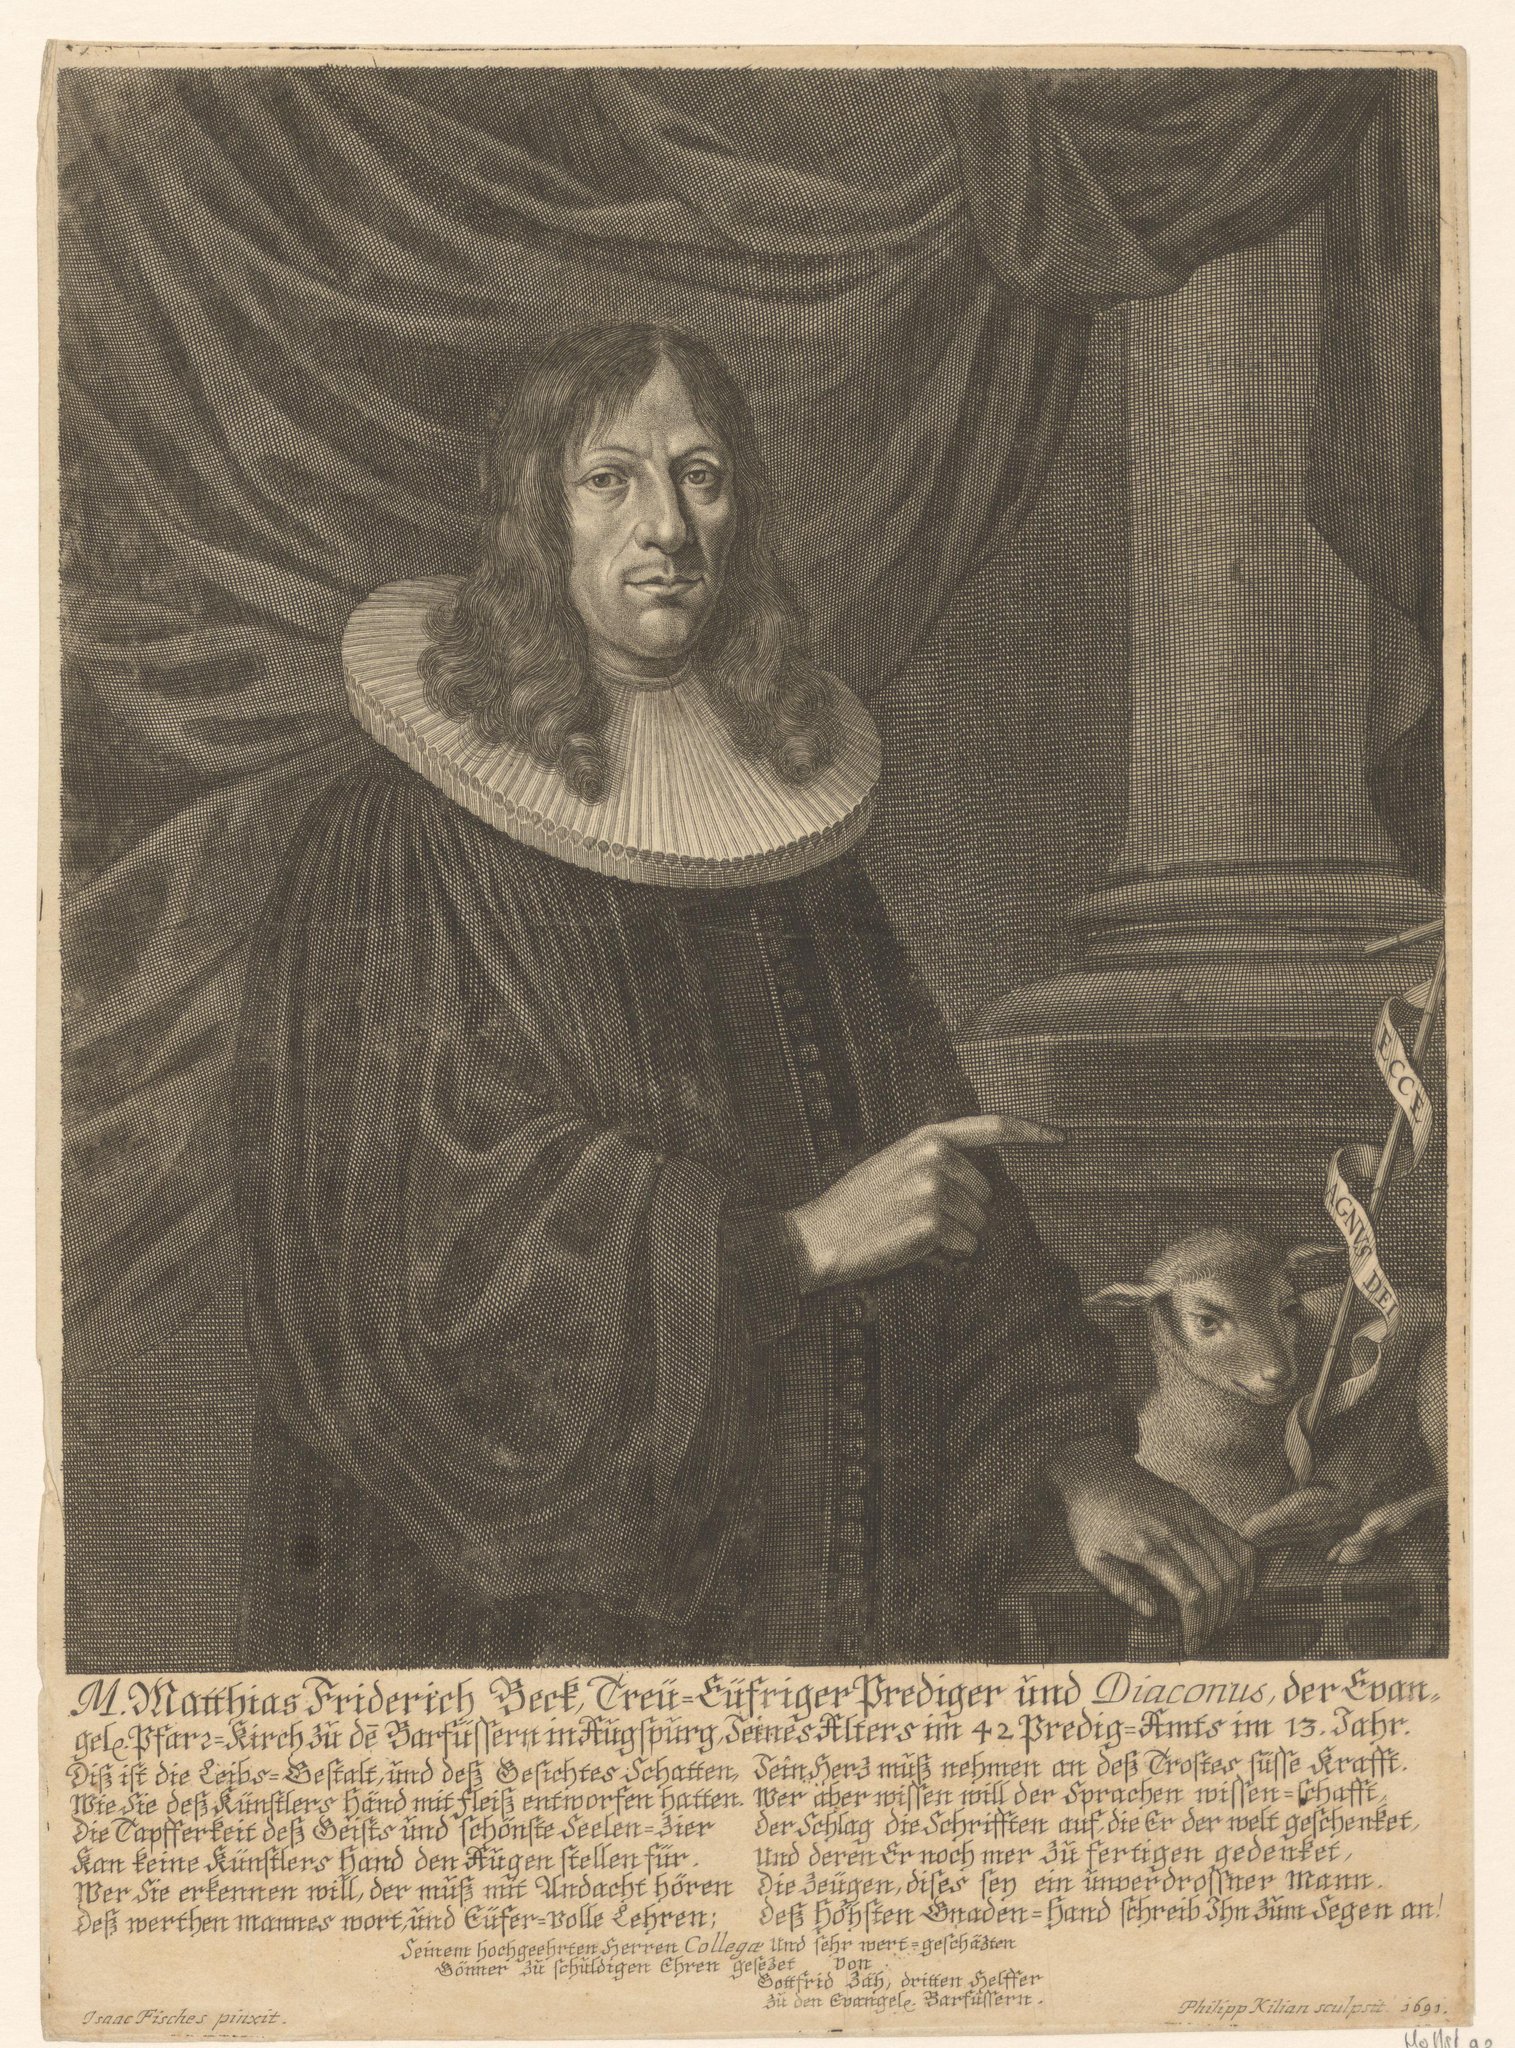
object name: print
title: Portret van Matthias Friedrich Beck op 42-jarige leeftijd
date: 1691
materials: paper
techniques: engraving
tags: philology (+ portrait of scholar, scientist), lamb bearing cross or banner, 'agnus dei' ~ symbol of christ, ethnology, cultural anthropology (+ portrait of scholar, scientist), historical persons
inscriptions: collector's mark: Lugt 2228